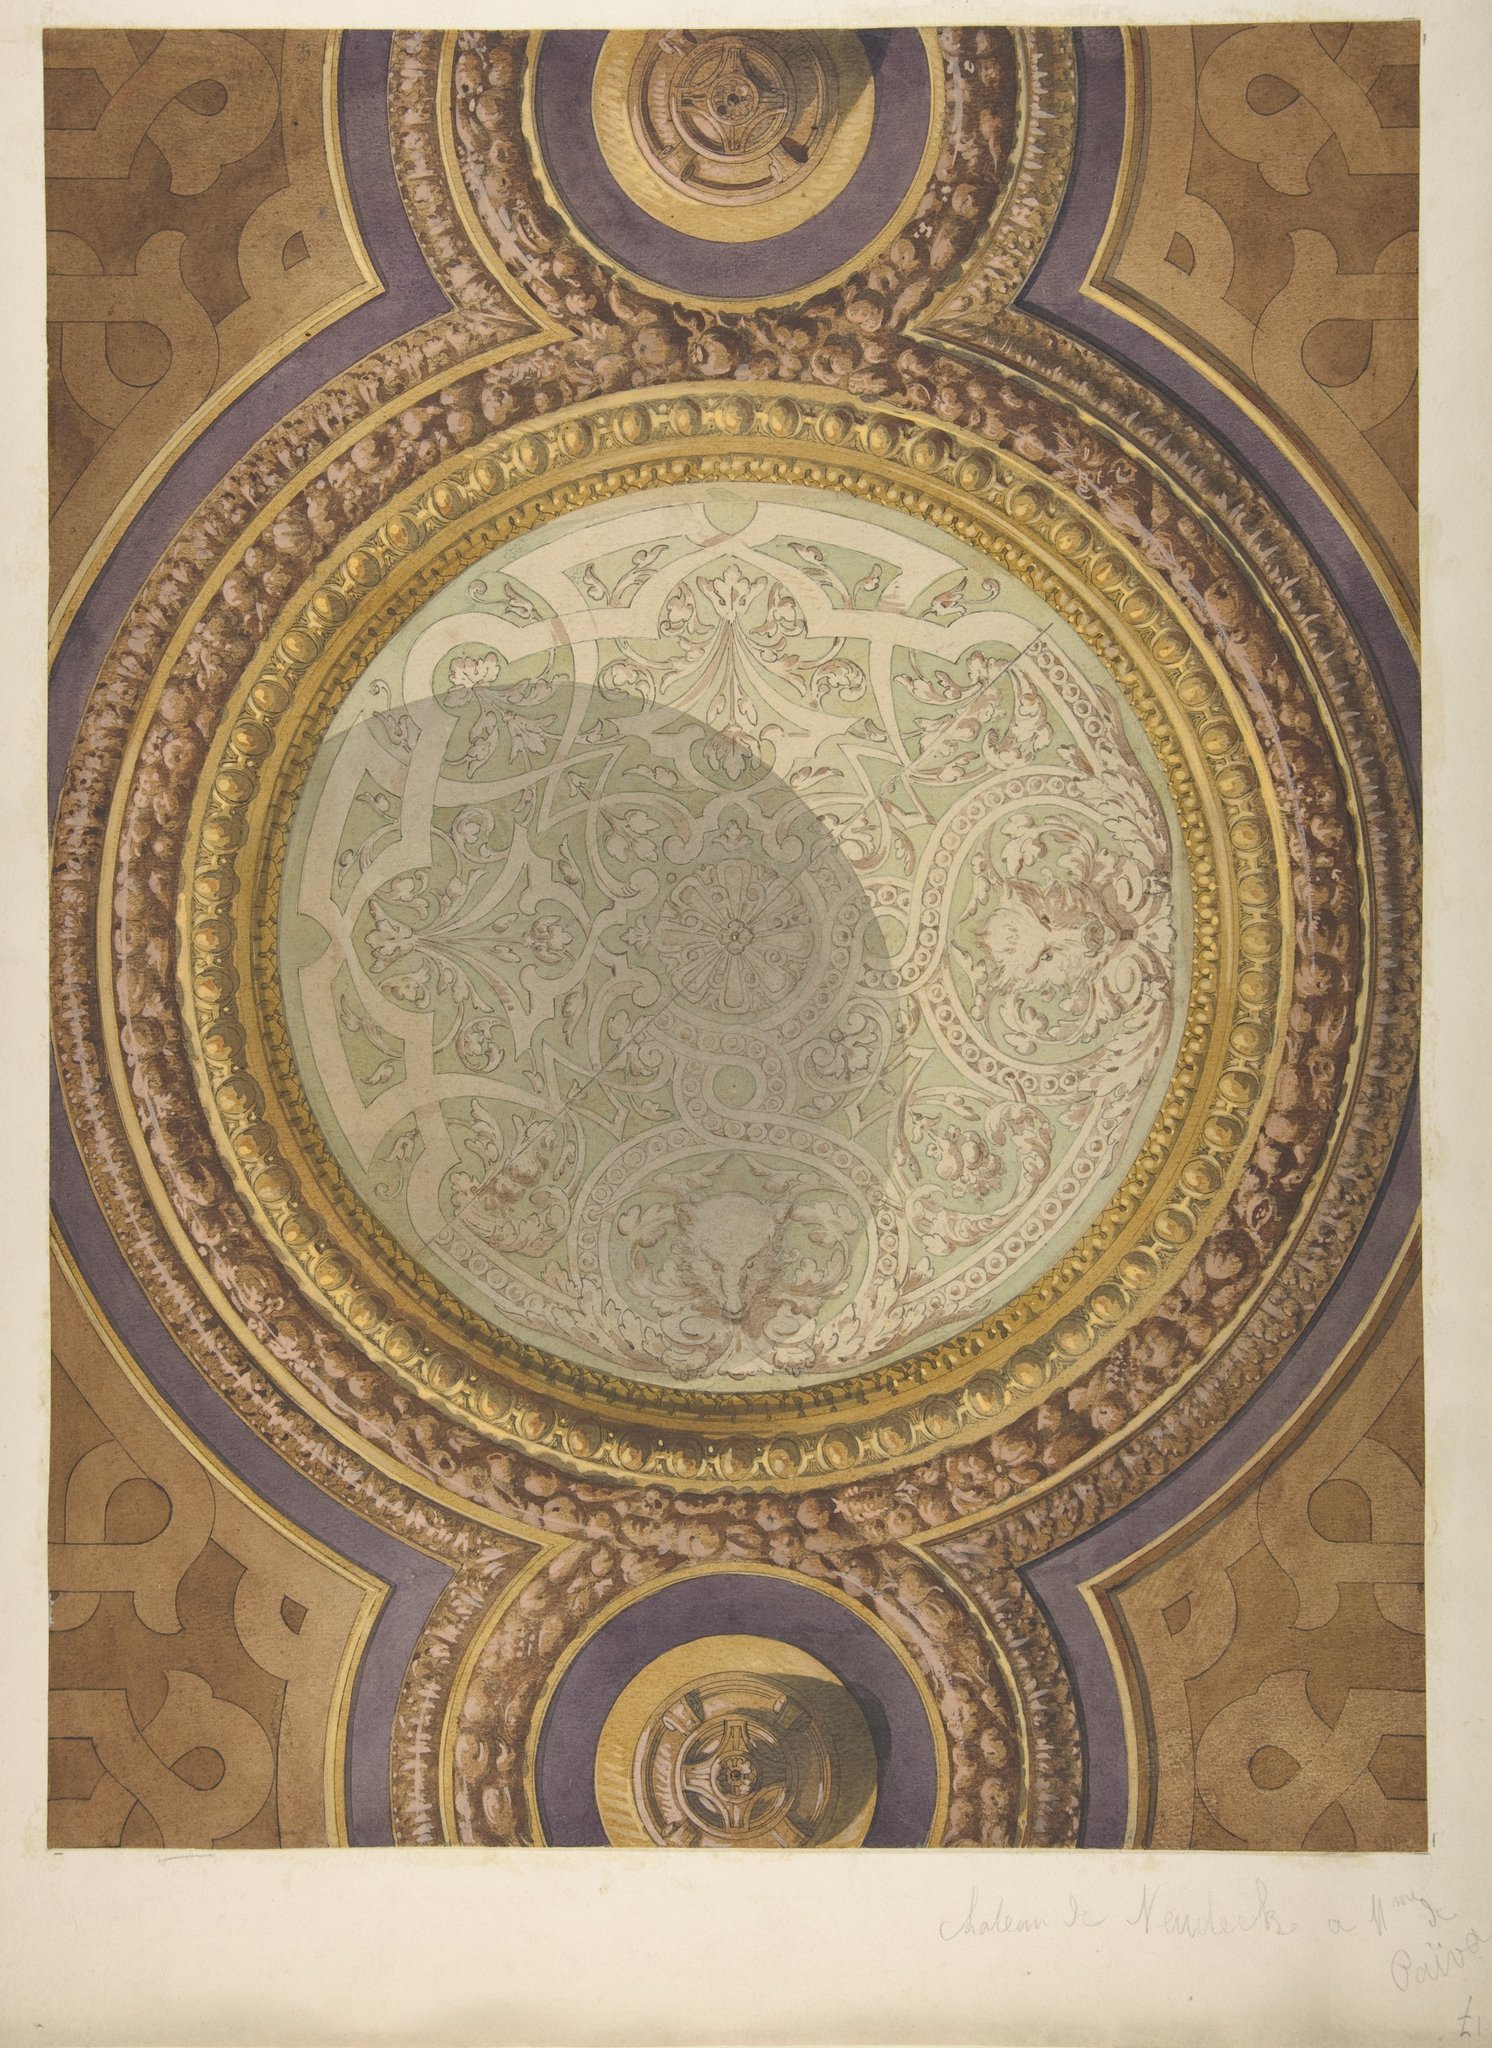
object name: drawing ornament architecture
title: Design for Domed Ceiling for Mme Païva's Chateau at Neudeck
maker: jules-edmond-charles lachaise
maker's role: artist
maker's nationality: french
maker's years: 1897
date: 1877-1884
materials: gouache, ink, watercolor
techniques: pen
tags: animals,architecture,ornament